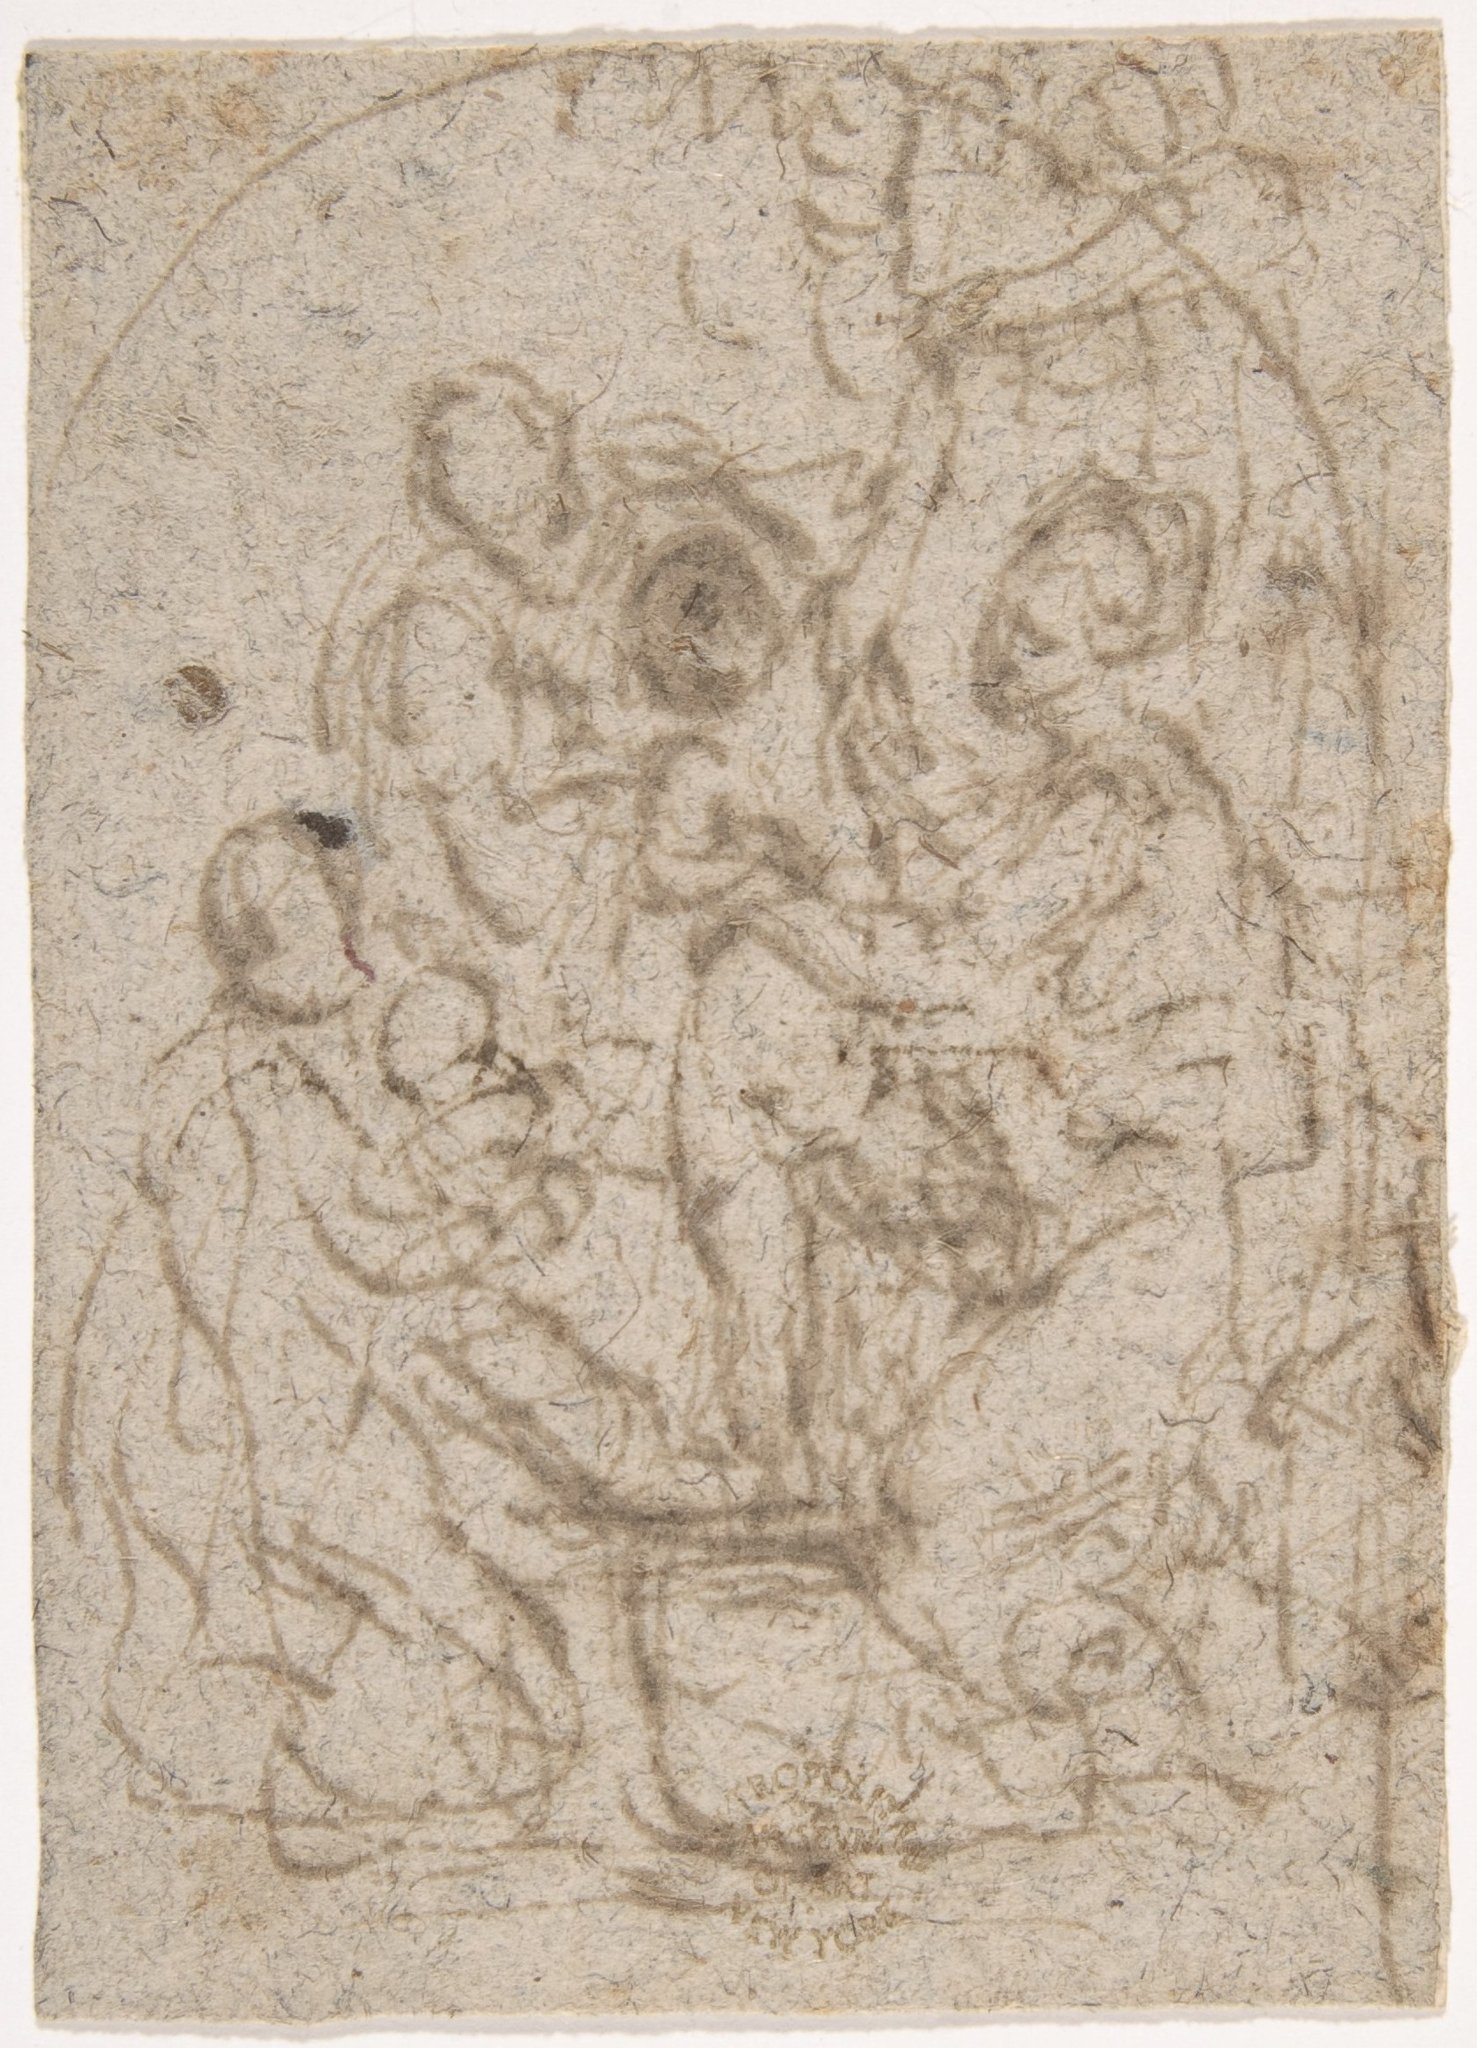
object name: drawing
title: Madonna and a Group of Saints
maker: anonymous, italian, 16th century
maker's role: artist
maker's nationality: italian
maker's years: 1550-1600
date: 1501-1600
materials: ink, paper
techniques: pen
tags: madonna,saints